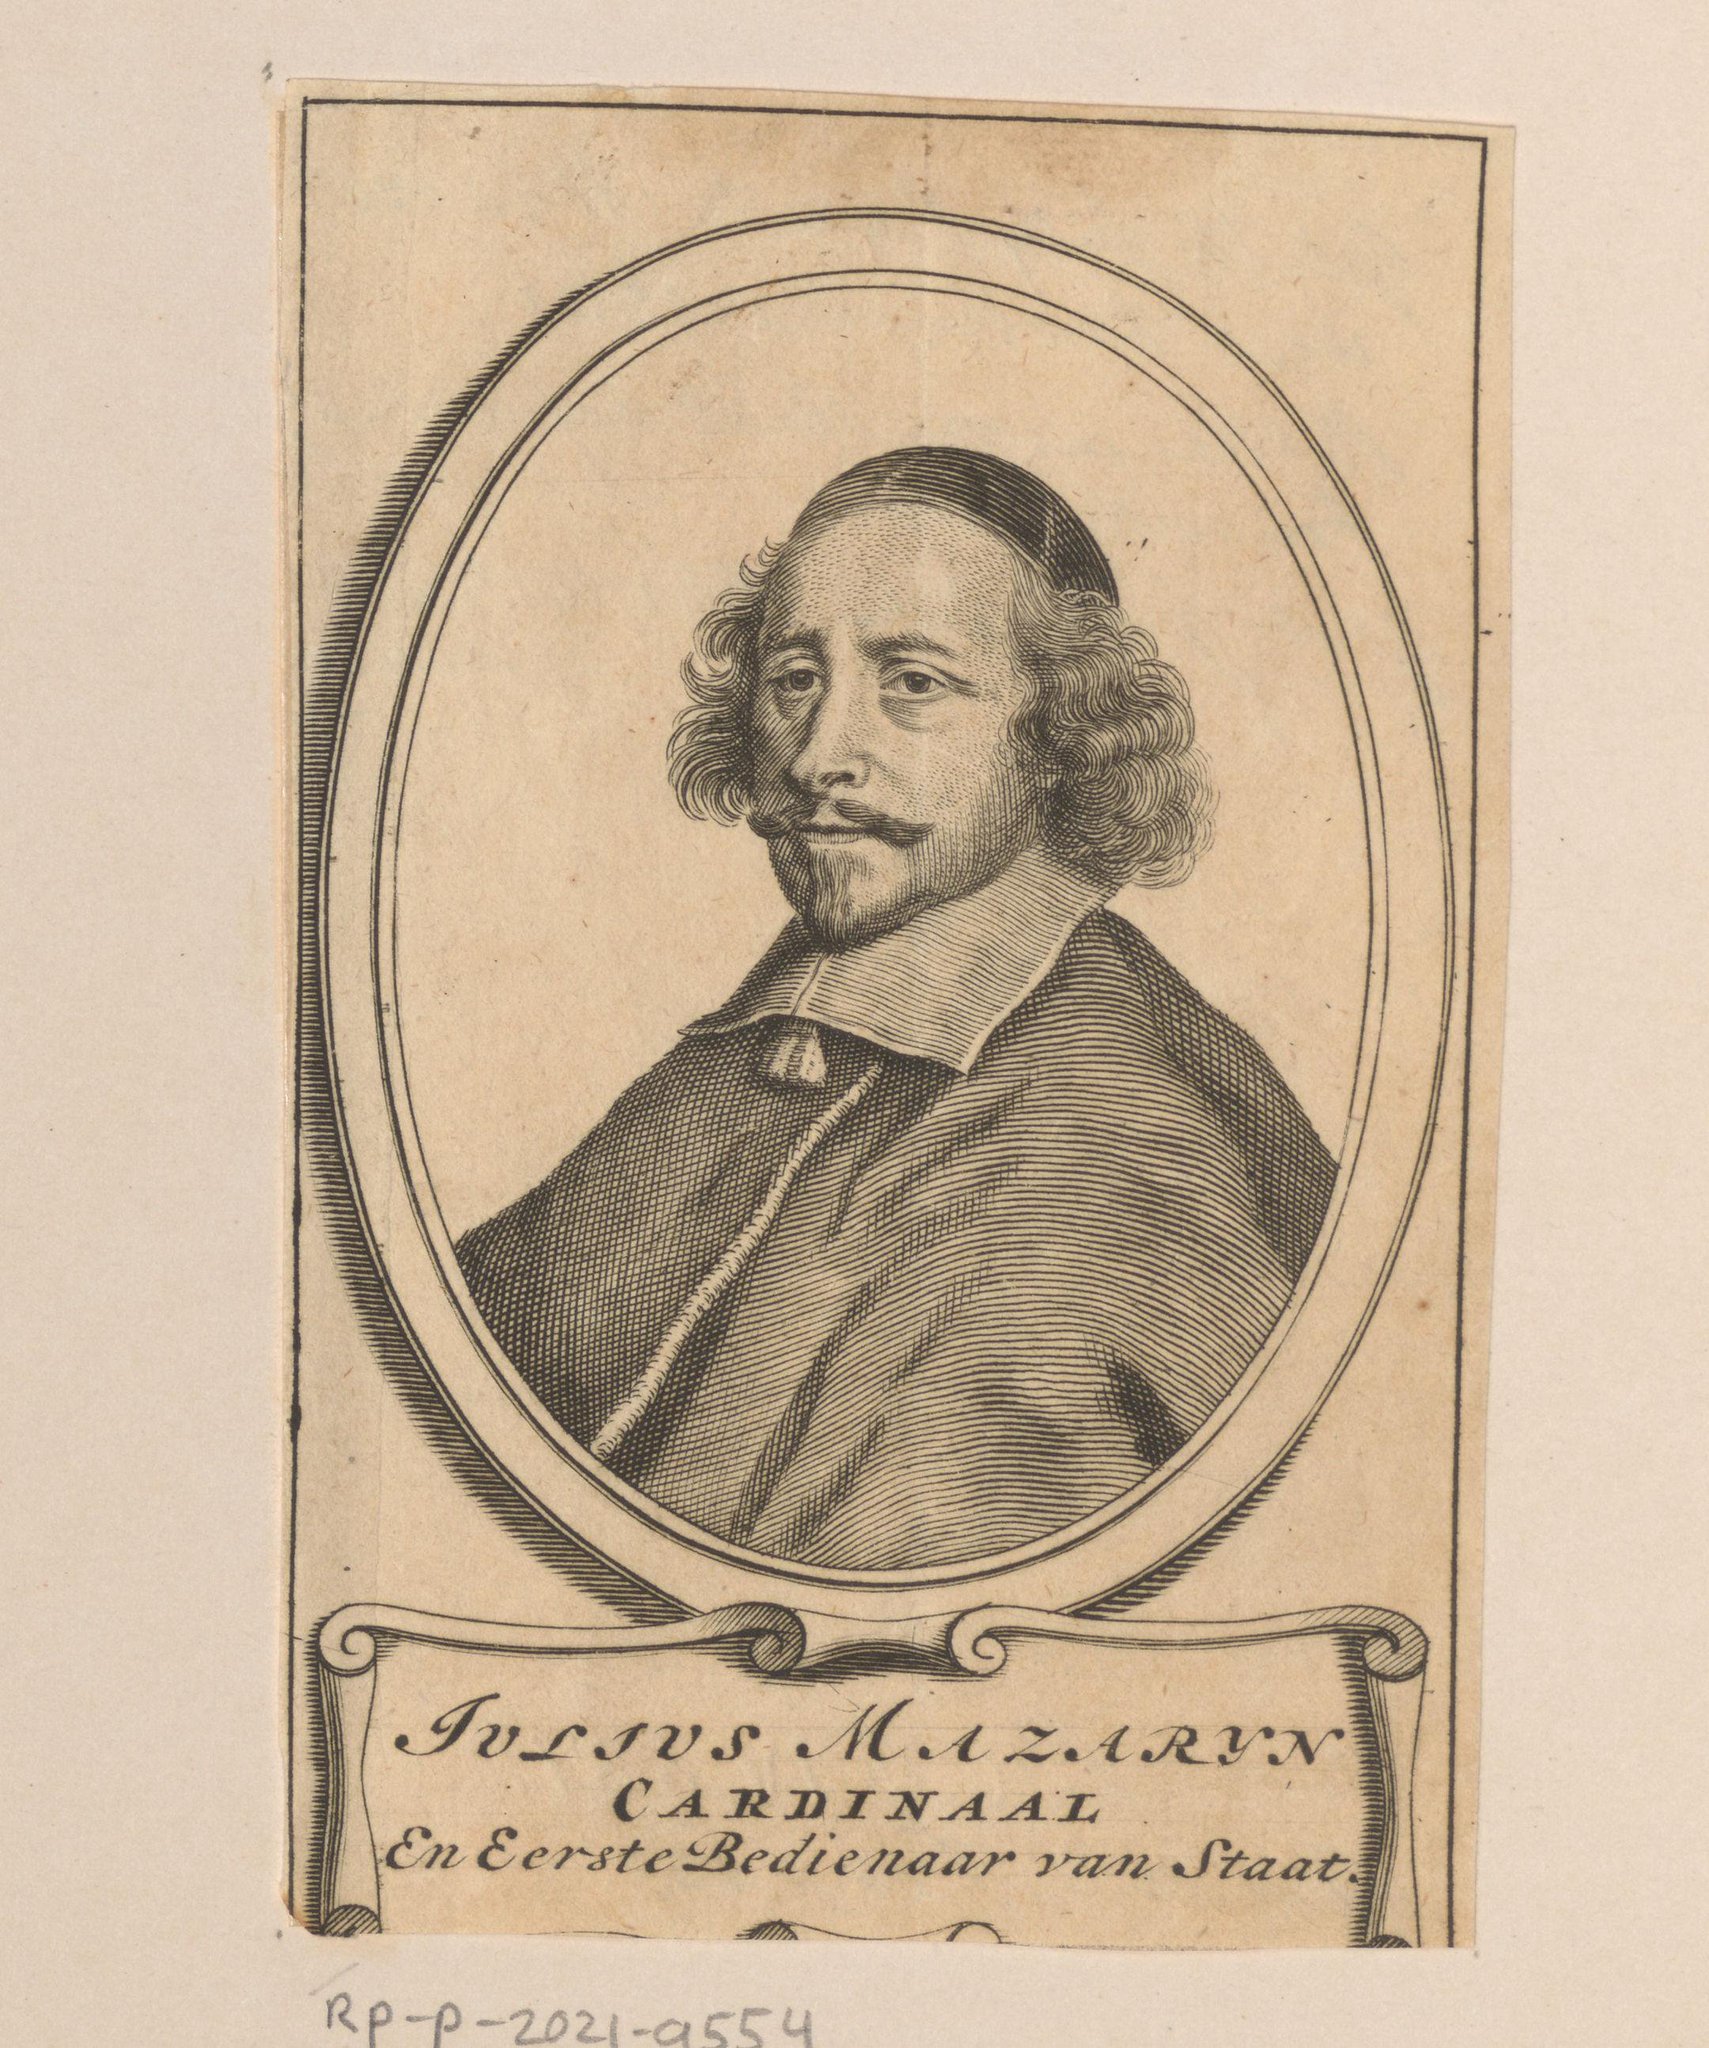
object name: book illustration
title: Portret van Jules Mazarin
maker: Anonymous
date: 1699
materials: paper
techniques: engraving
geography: northern netherlands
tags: jules mazarin, ornament ~ medallion, cardinal, historical persons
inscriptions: inscription: ‘Geb 14 July 1602 te Abruzzo/ (...)’, inscription: ‘[...]T IV p 537’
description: Prent waarschijnlijk uit: Het leven en bedryf van den wytberoemden en grooten staatkundigen Julius Mazaryn (...). Leiden: Boudewijn van der Aa, 1699, dl. 1.